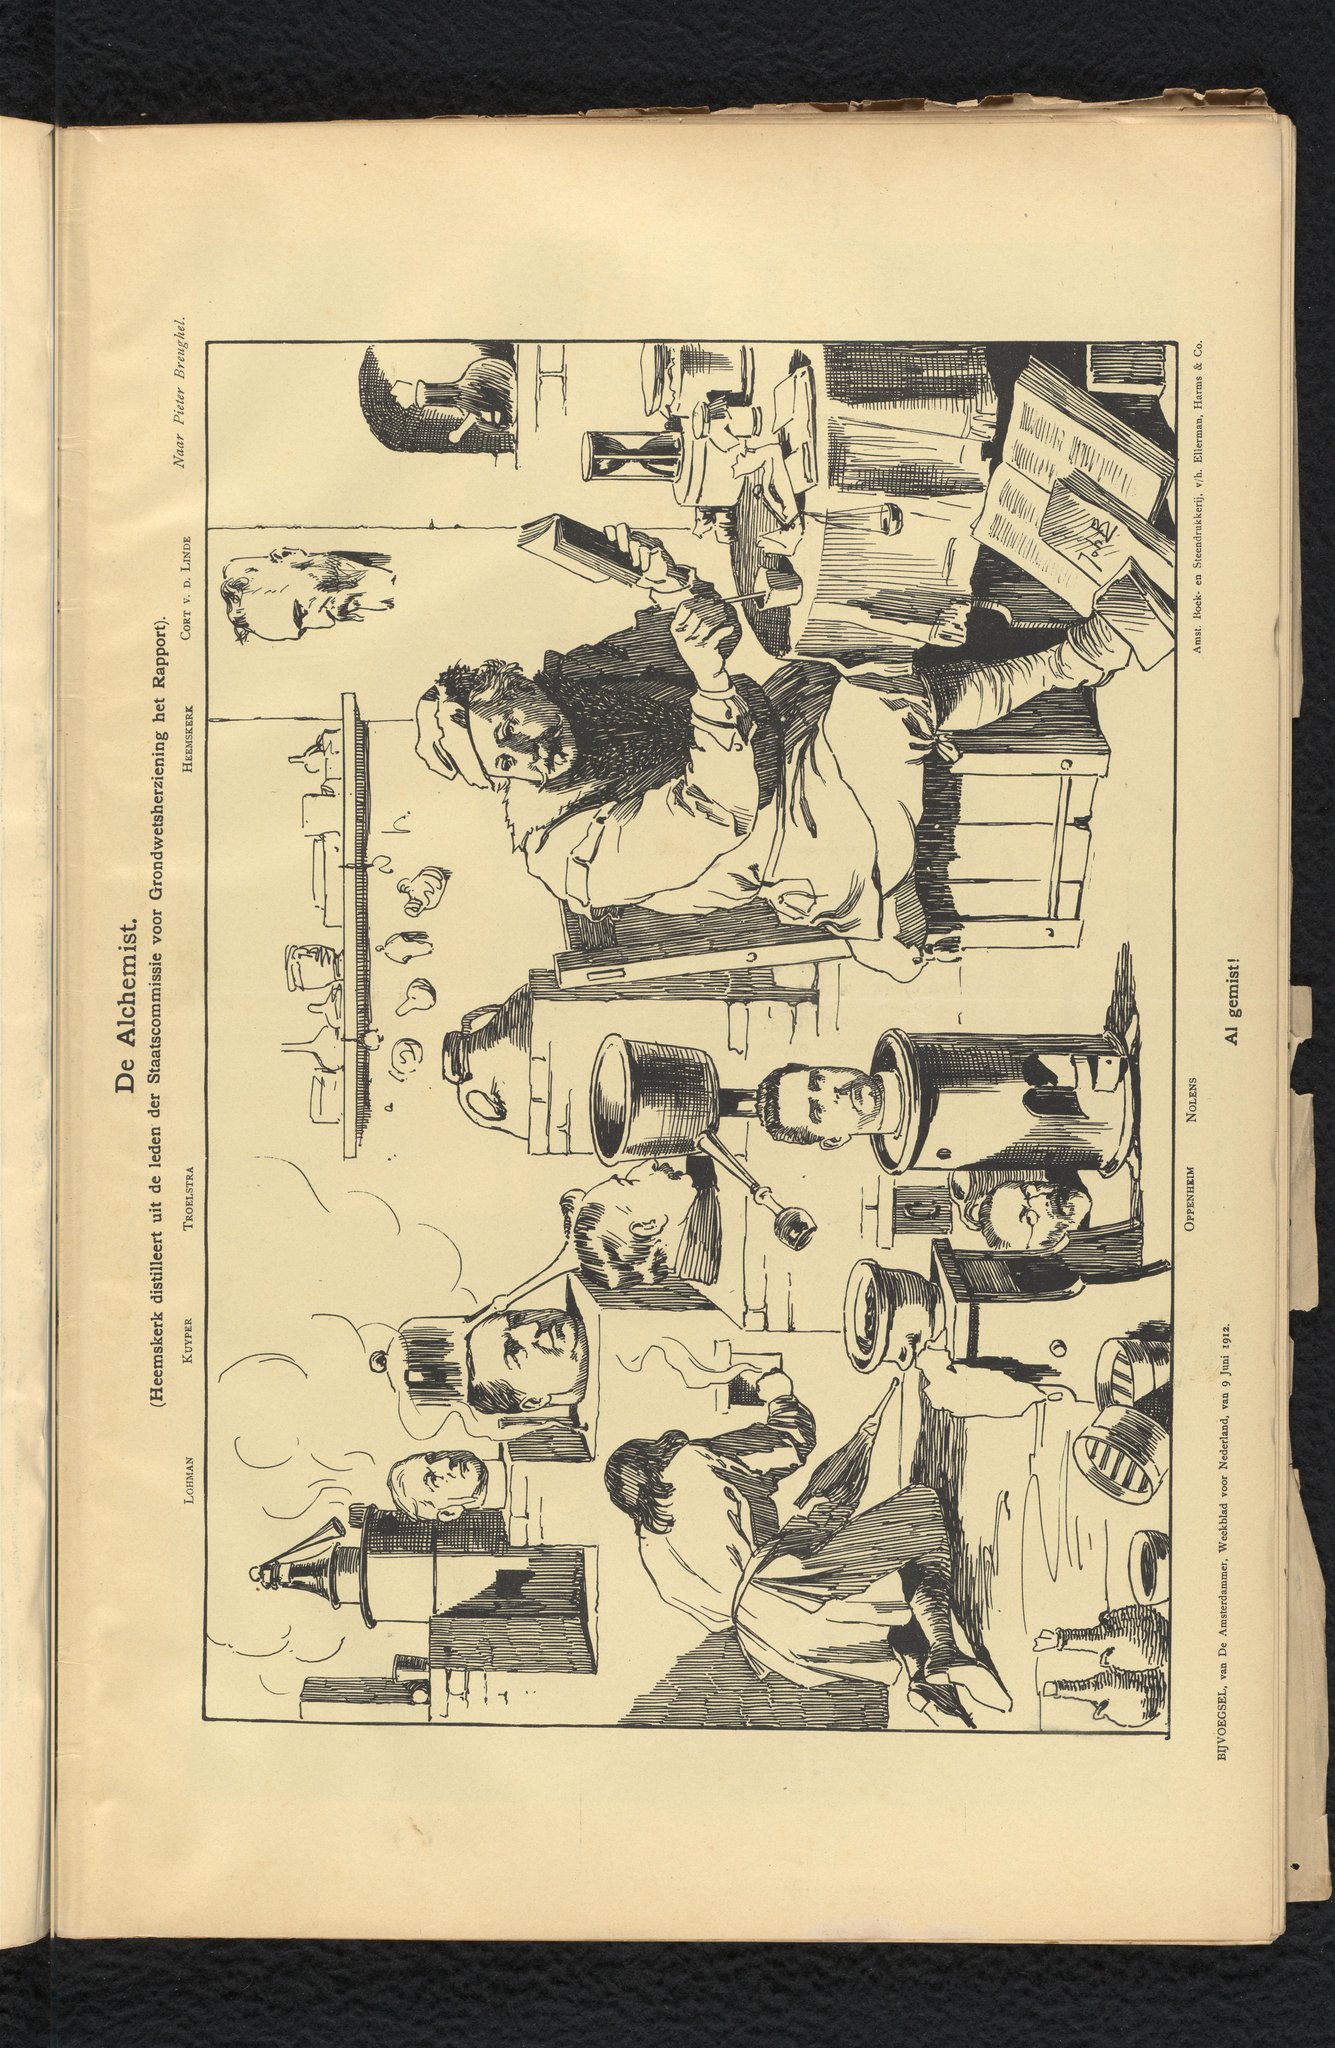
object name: cartoon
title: De Alchemist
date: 1912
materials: paper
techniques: lithograph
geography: amsterdam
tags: amsterdam, utrecht, alchemist at work, political caricatures and satires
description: Premier Heemskerk als een alchemist die in zijn werkplaats uit de hoofden van de leden van de Staatscommissie voor Grondwetsherziening zijn rapport destilleert. Naar de prent van Pieter Bruegel de Oude.